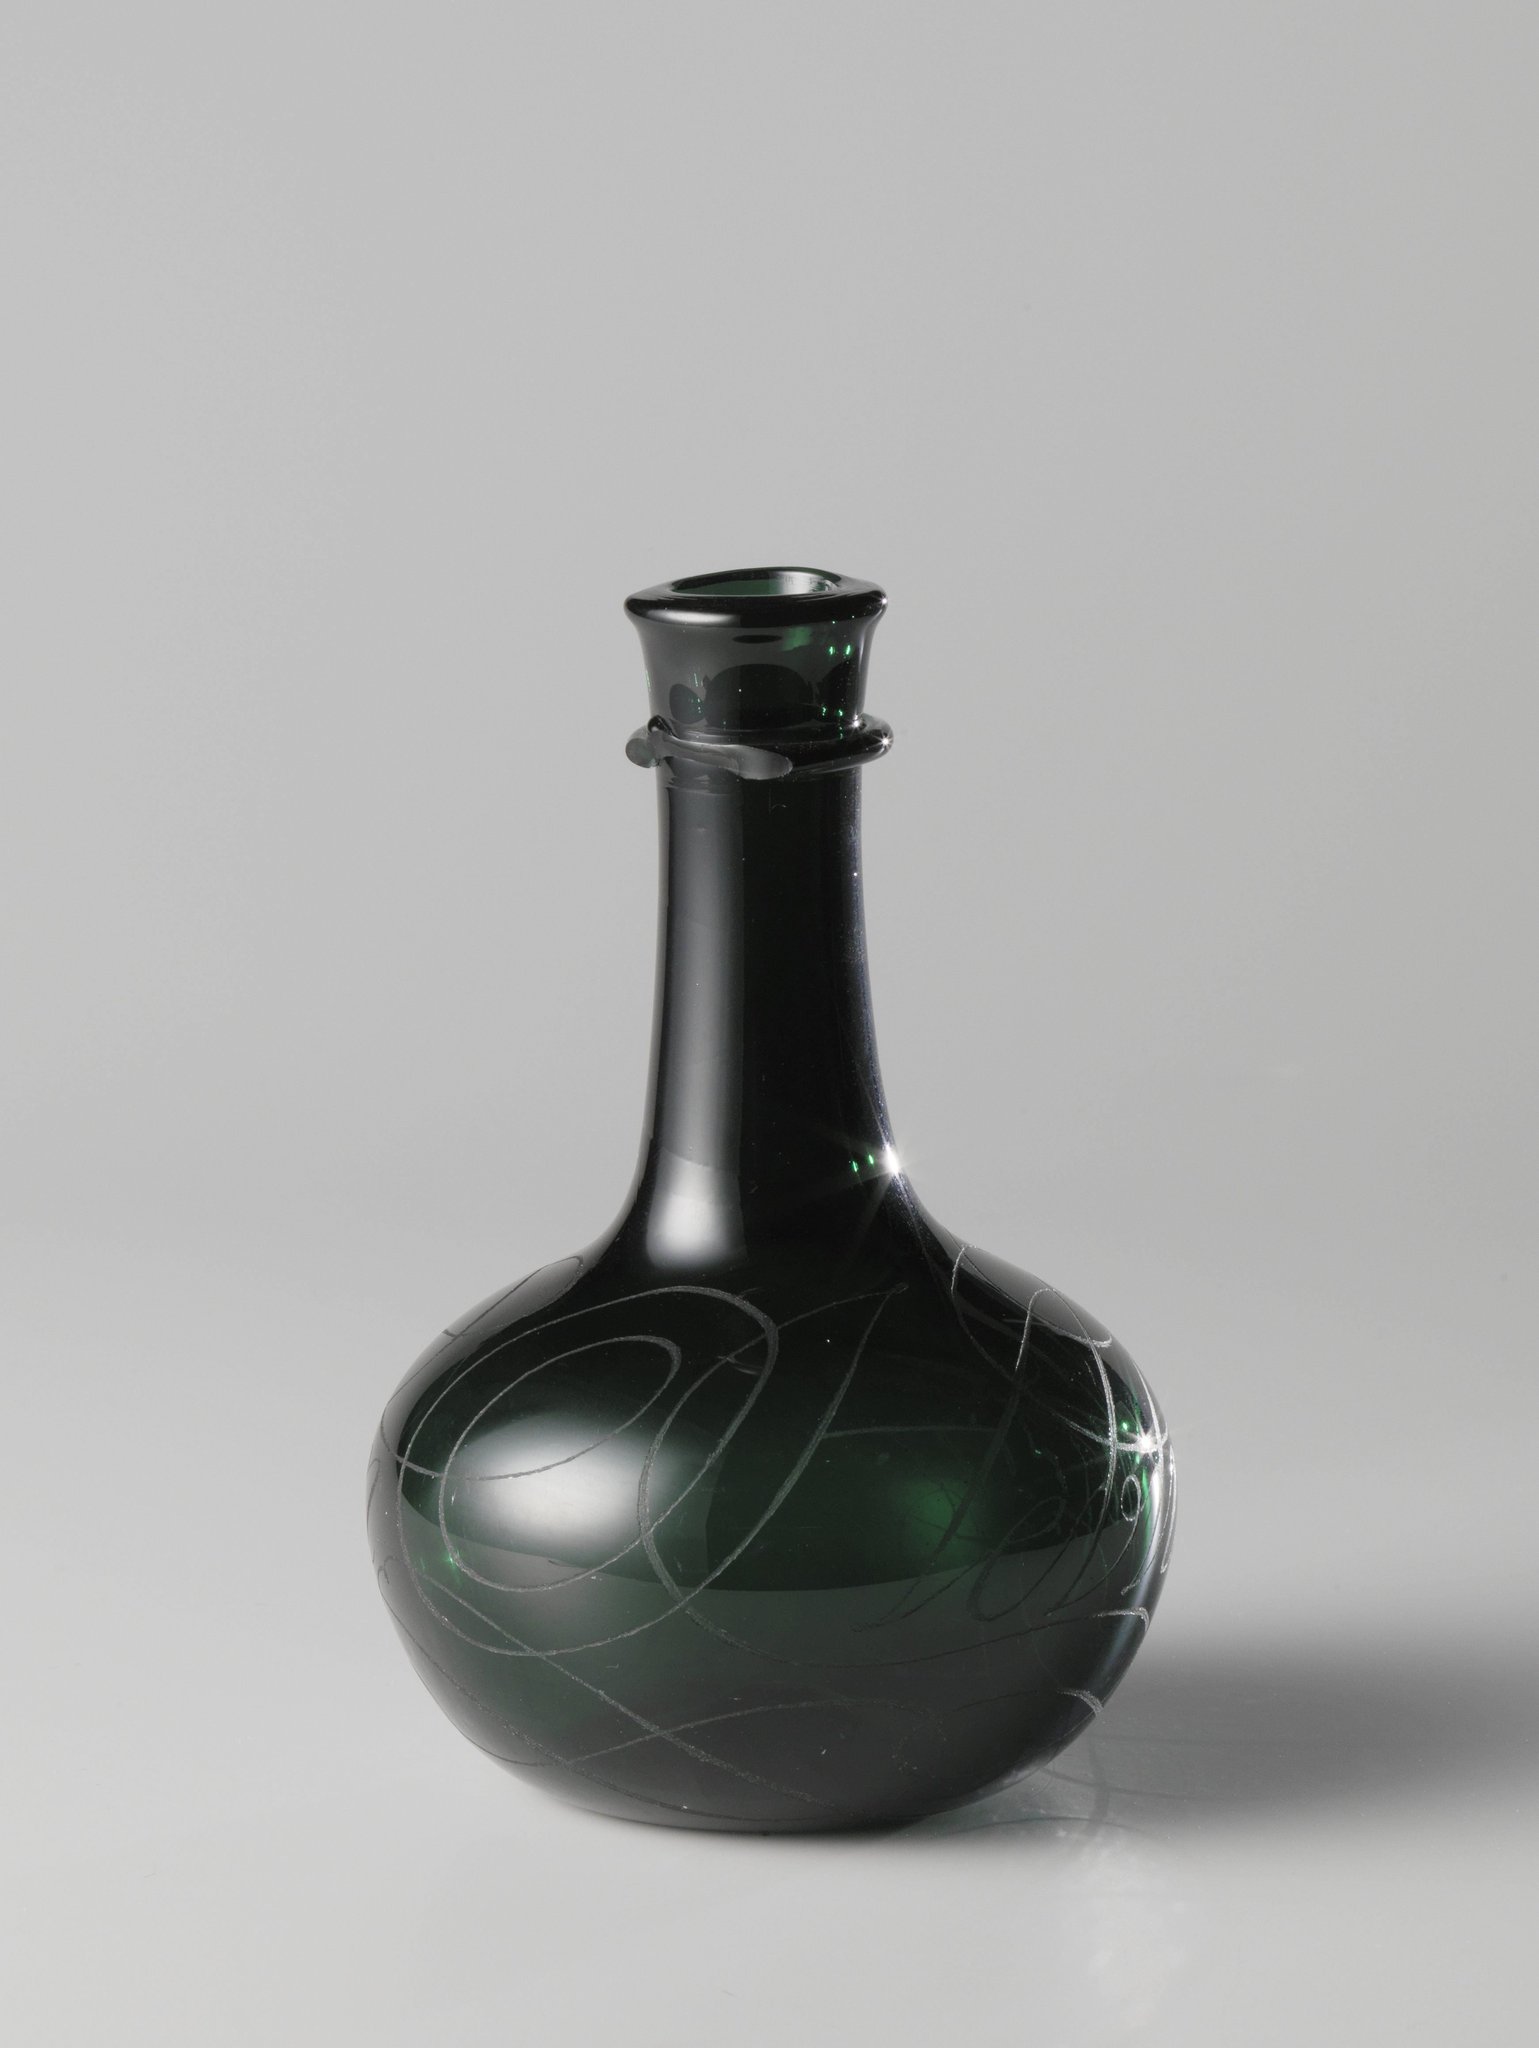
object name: bottle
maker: willem jacobszoon van heemskerk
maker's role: dichter, glasgraveur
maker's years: 1613-1692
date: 1676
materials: glass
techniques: diamond point engraving, glassblowing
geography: leiden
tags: leiden, willem jacobszoon van heemskerk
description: The inscription on the body of the bottle translates as: ‘Greed makes poverty’. The same text is engraved on the base, which is also signed and dated.